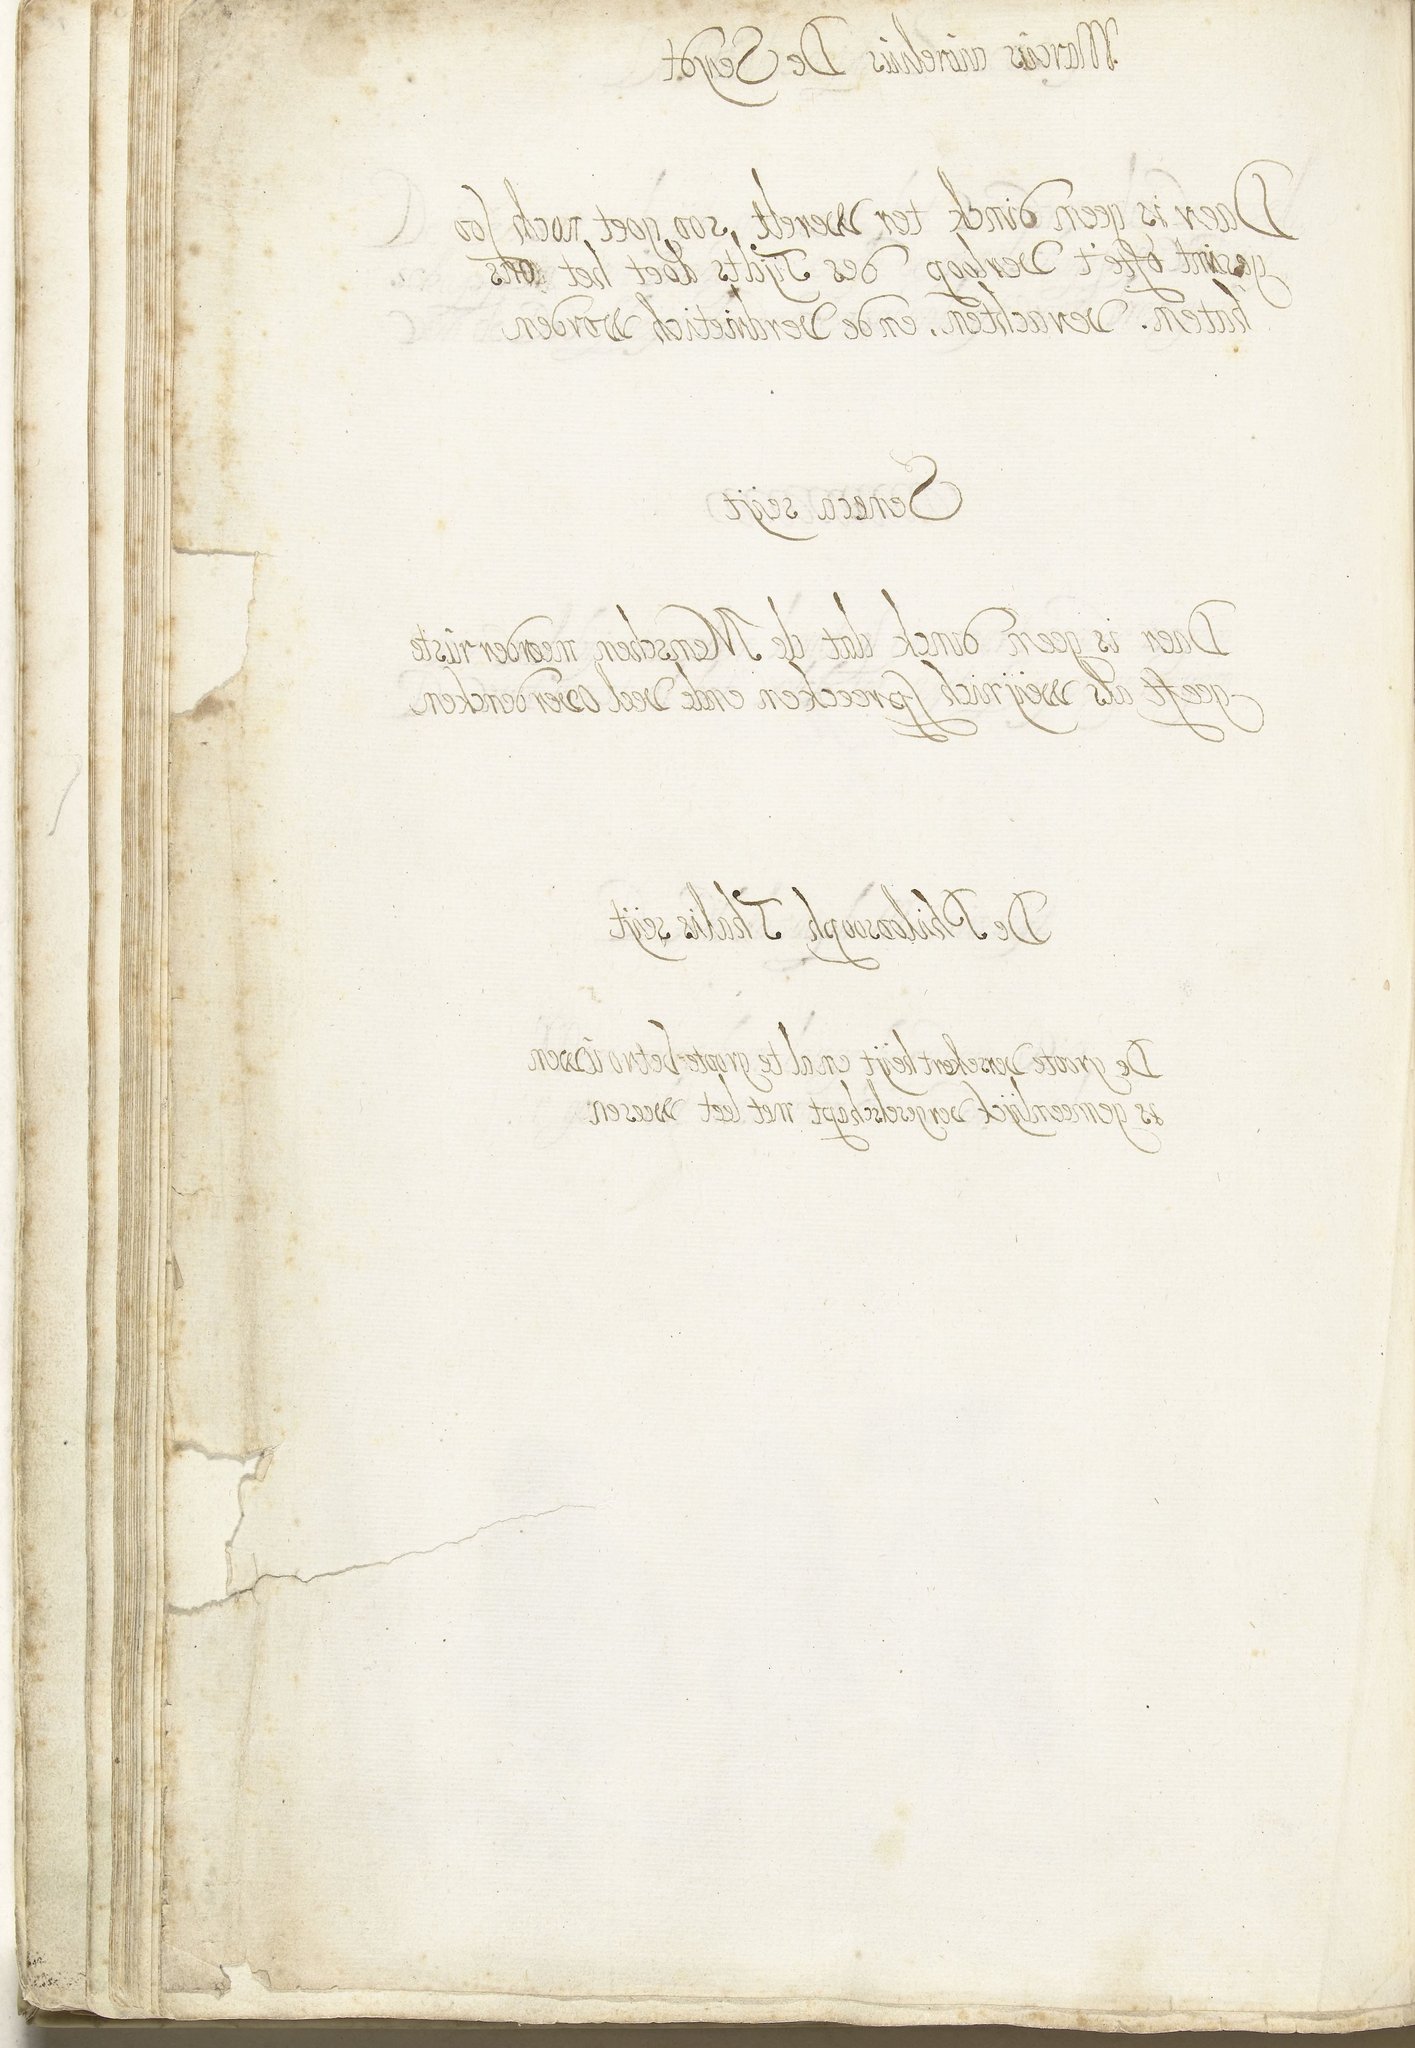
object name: calligraphy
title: Klassieke aforismen in spiegelbeeld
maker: gesina ter borch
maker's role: draughtsman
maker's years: 1633-1690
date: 1652-1680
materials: ink, paper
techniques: calligraphy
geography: zwolle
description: Het blad is later aan het Album toegevoegd en genummerd toen het opnieuw ingebonden werd.